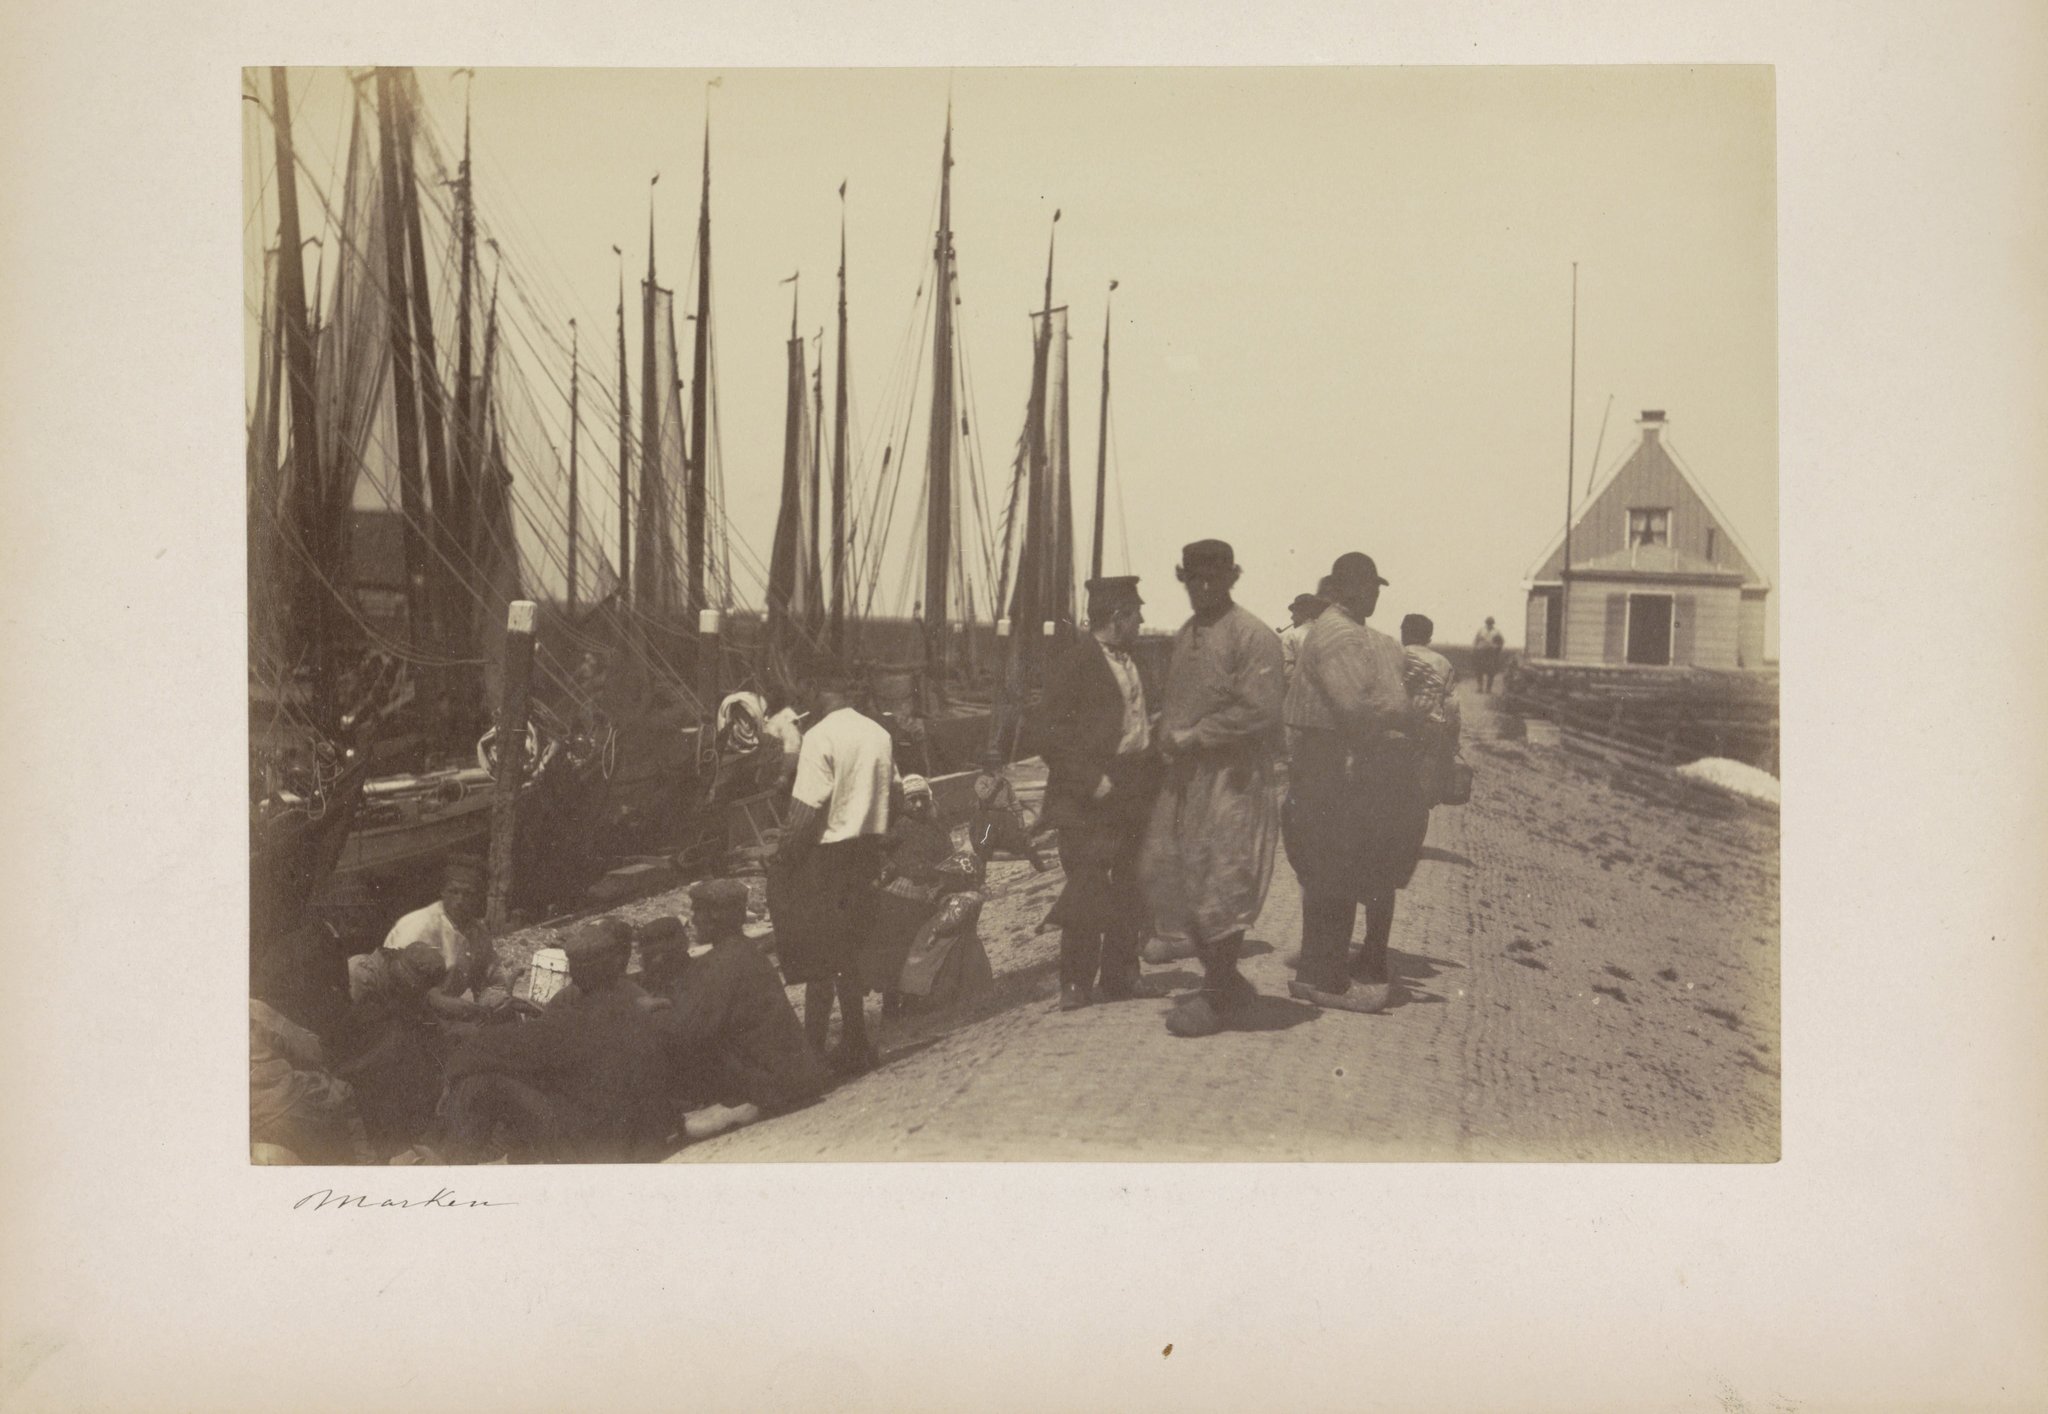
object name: photograph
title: Hollande, Marken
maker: Anonymous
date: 1885-1900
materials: paper, photographic support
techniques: albumen print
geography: france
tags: harbour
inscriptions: annotation: ‘Hollande’, annotation: ‘Marken’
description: Bewoners in klederdracht in de haven van het eiland Marken, Nederland